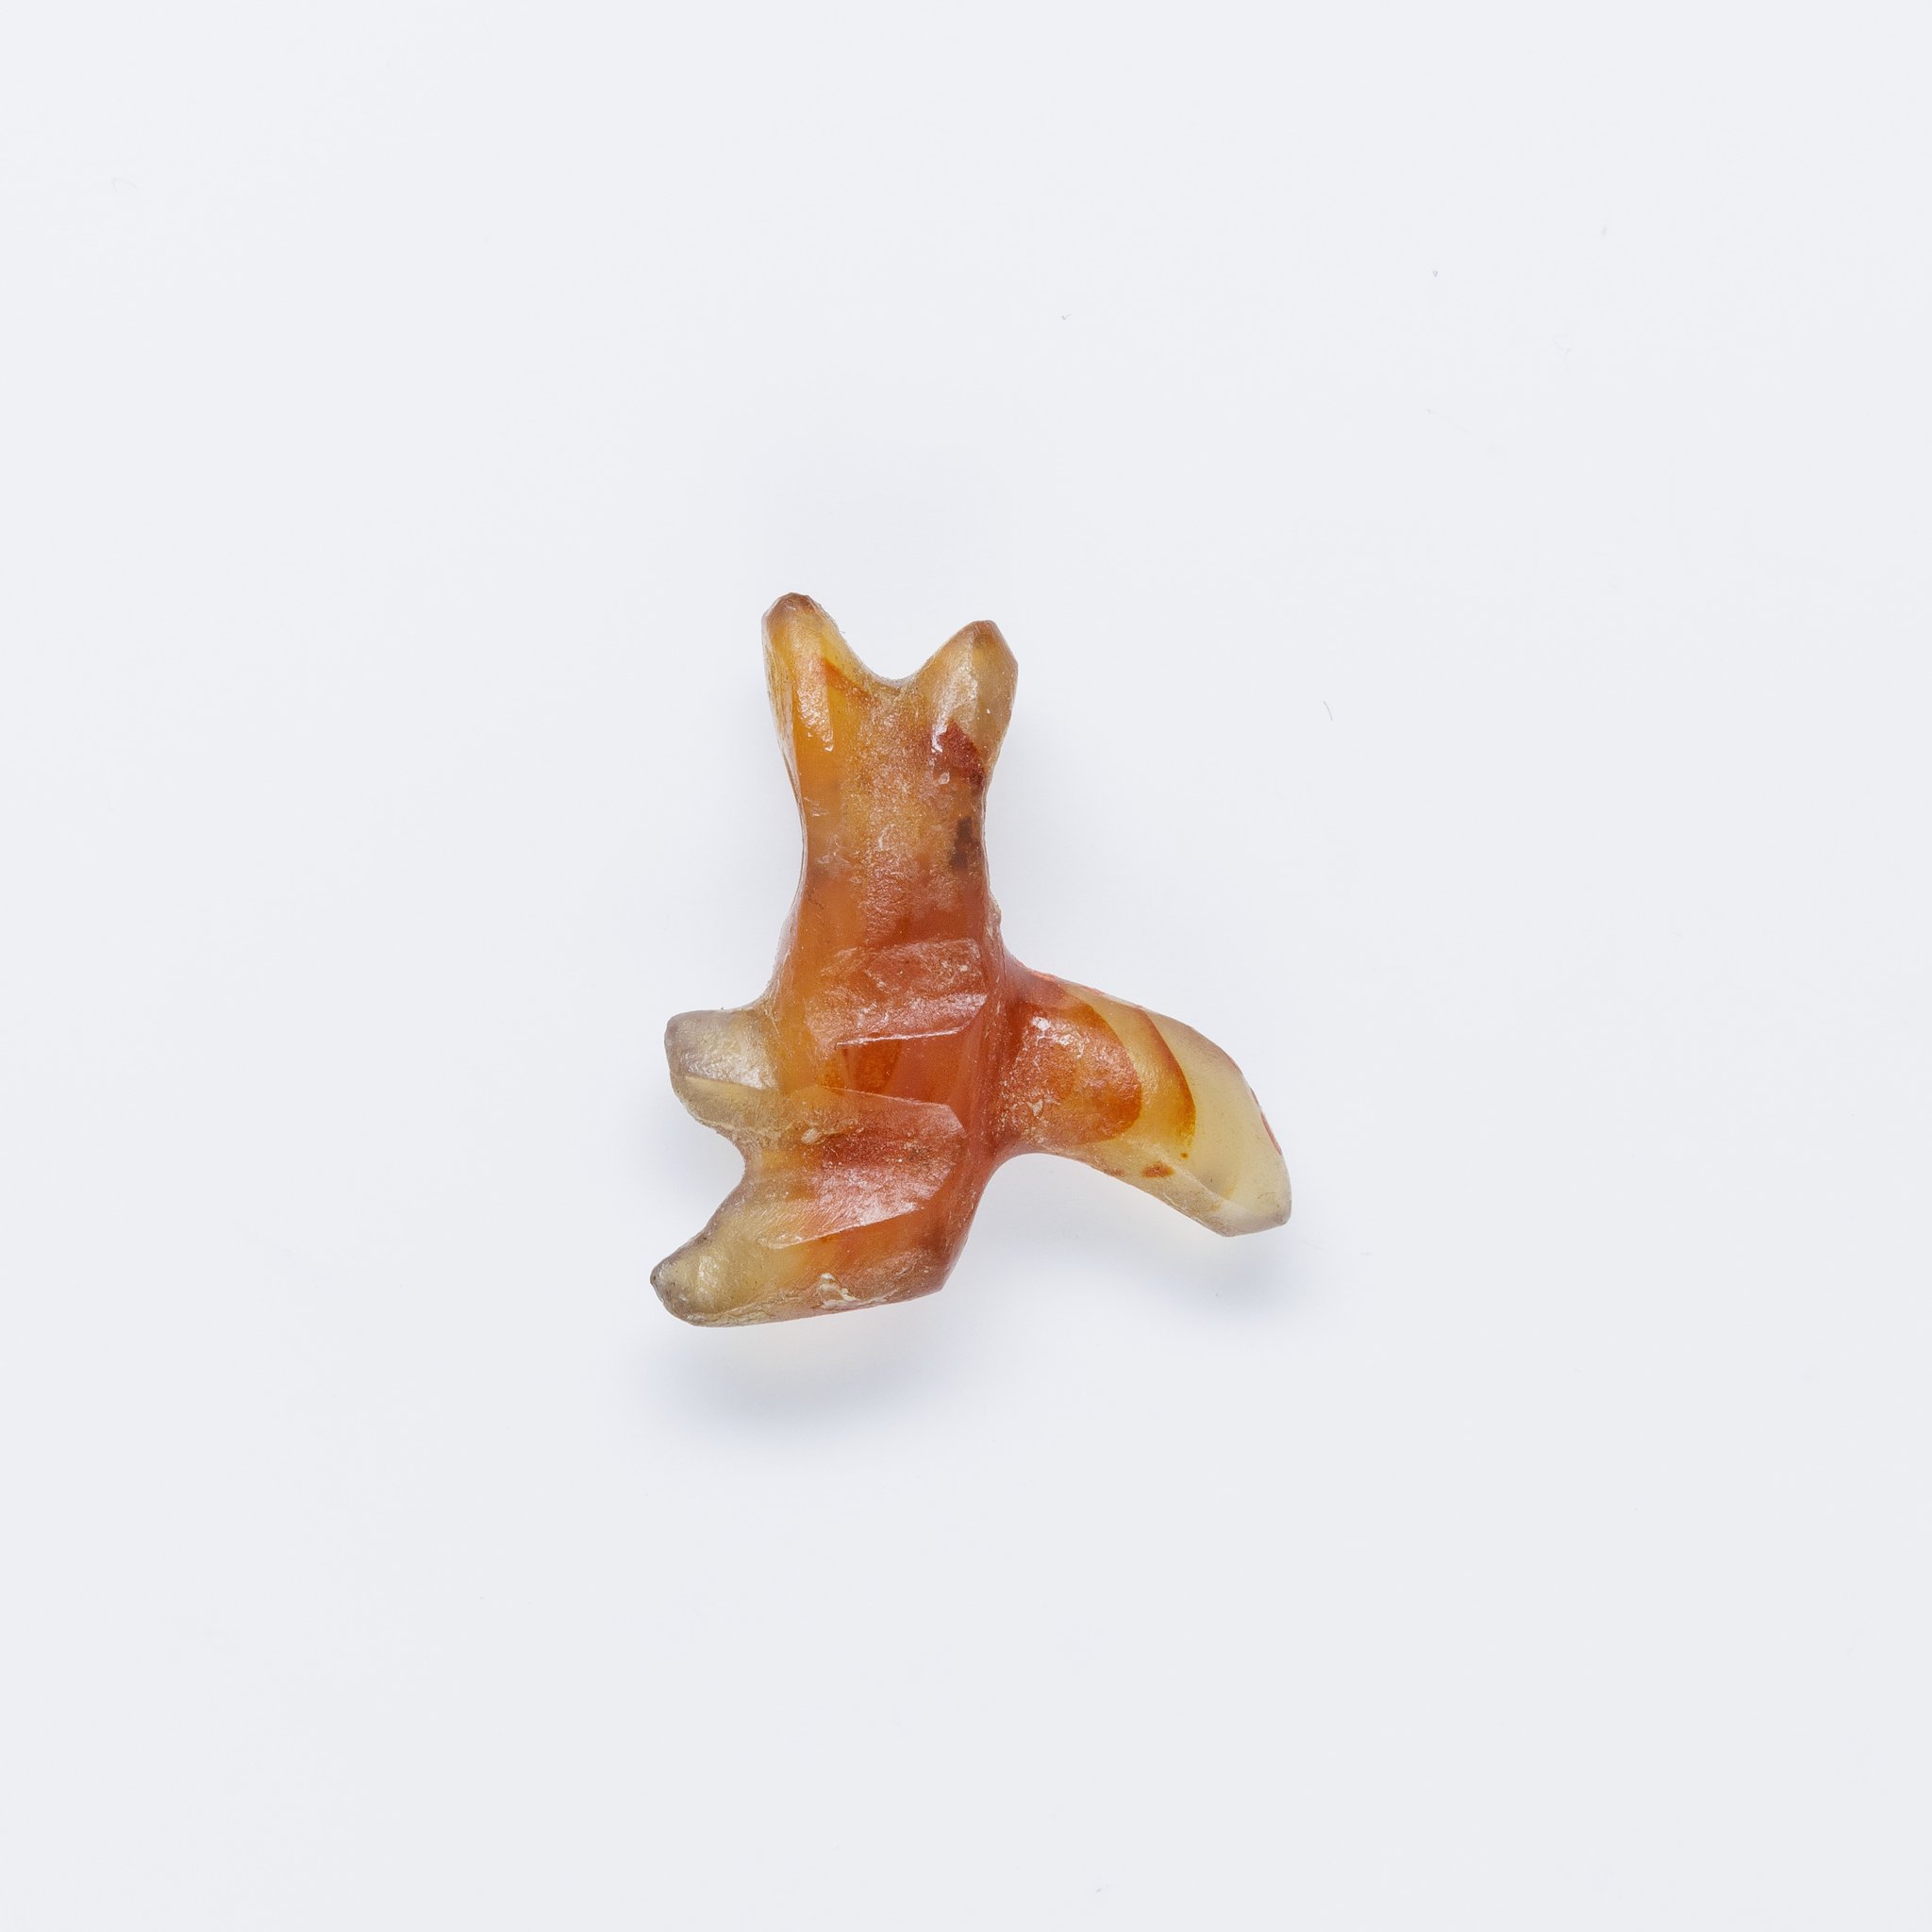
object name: amulet, bee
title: Bee amulet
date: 2150-1950 BCE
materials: gemstone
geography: southern upper egypt